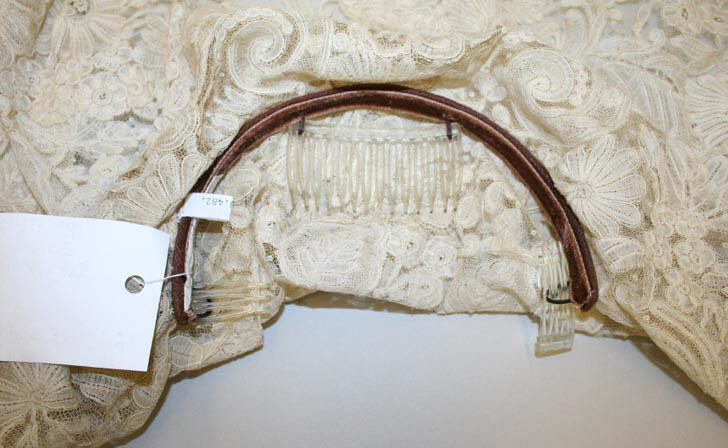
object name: wedding veil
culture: european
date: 1867-1900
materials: cotton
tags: flowers